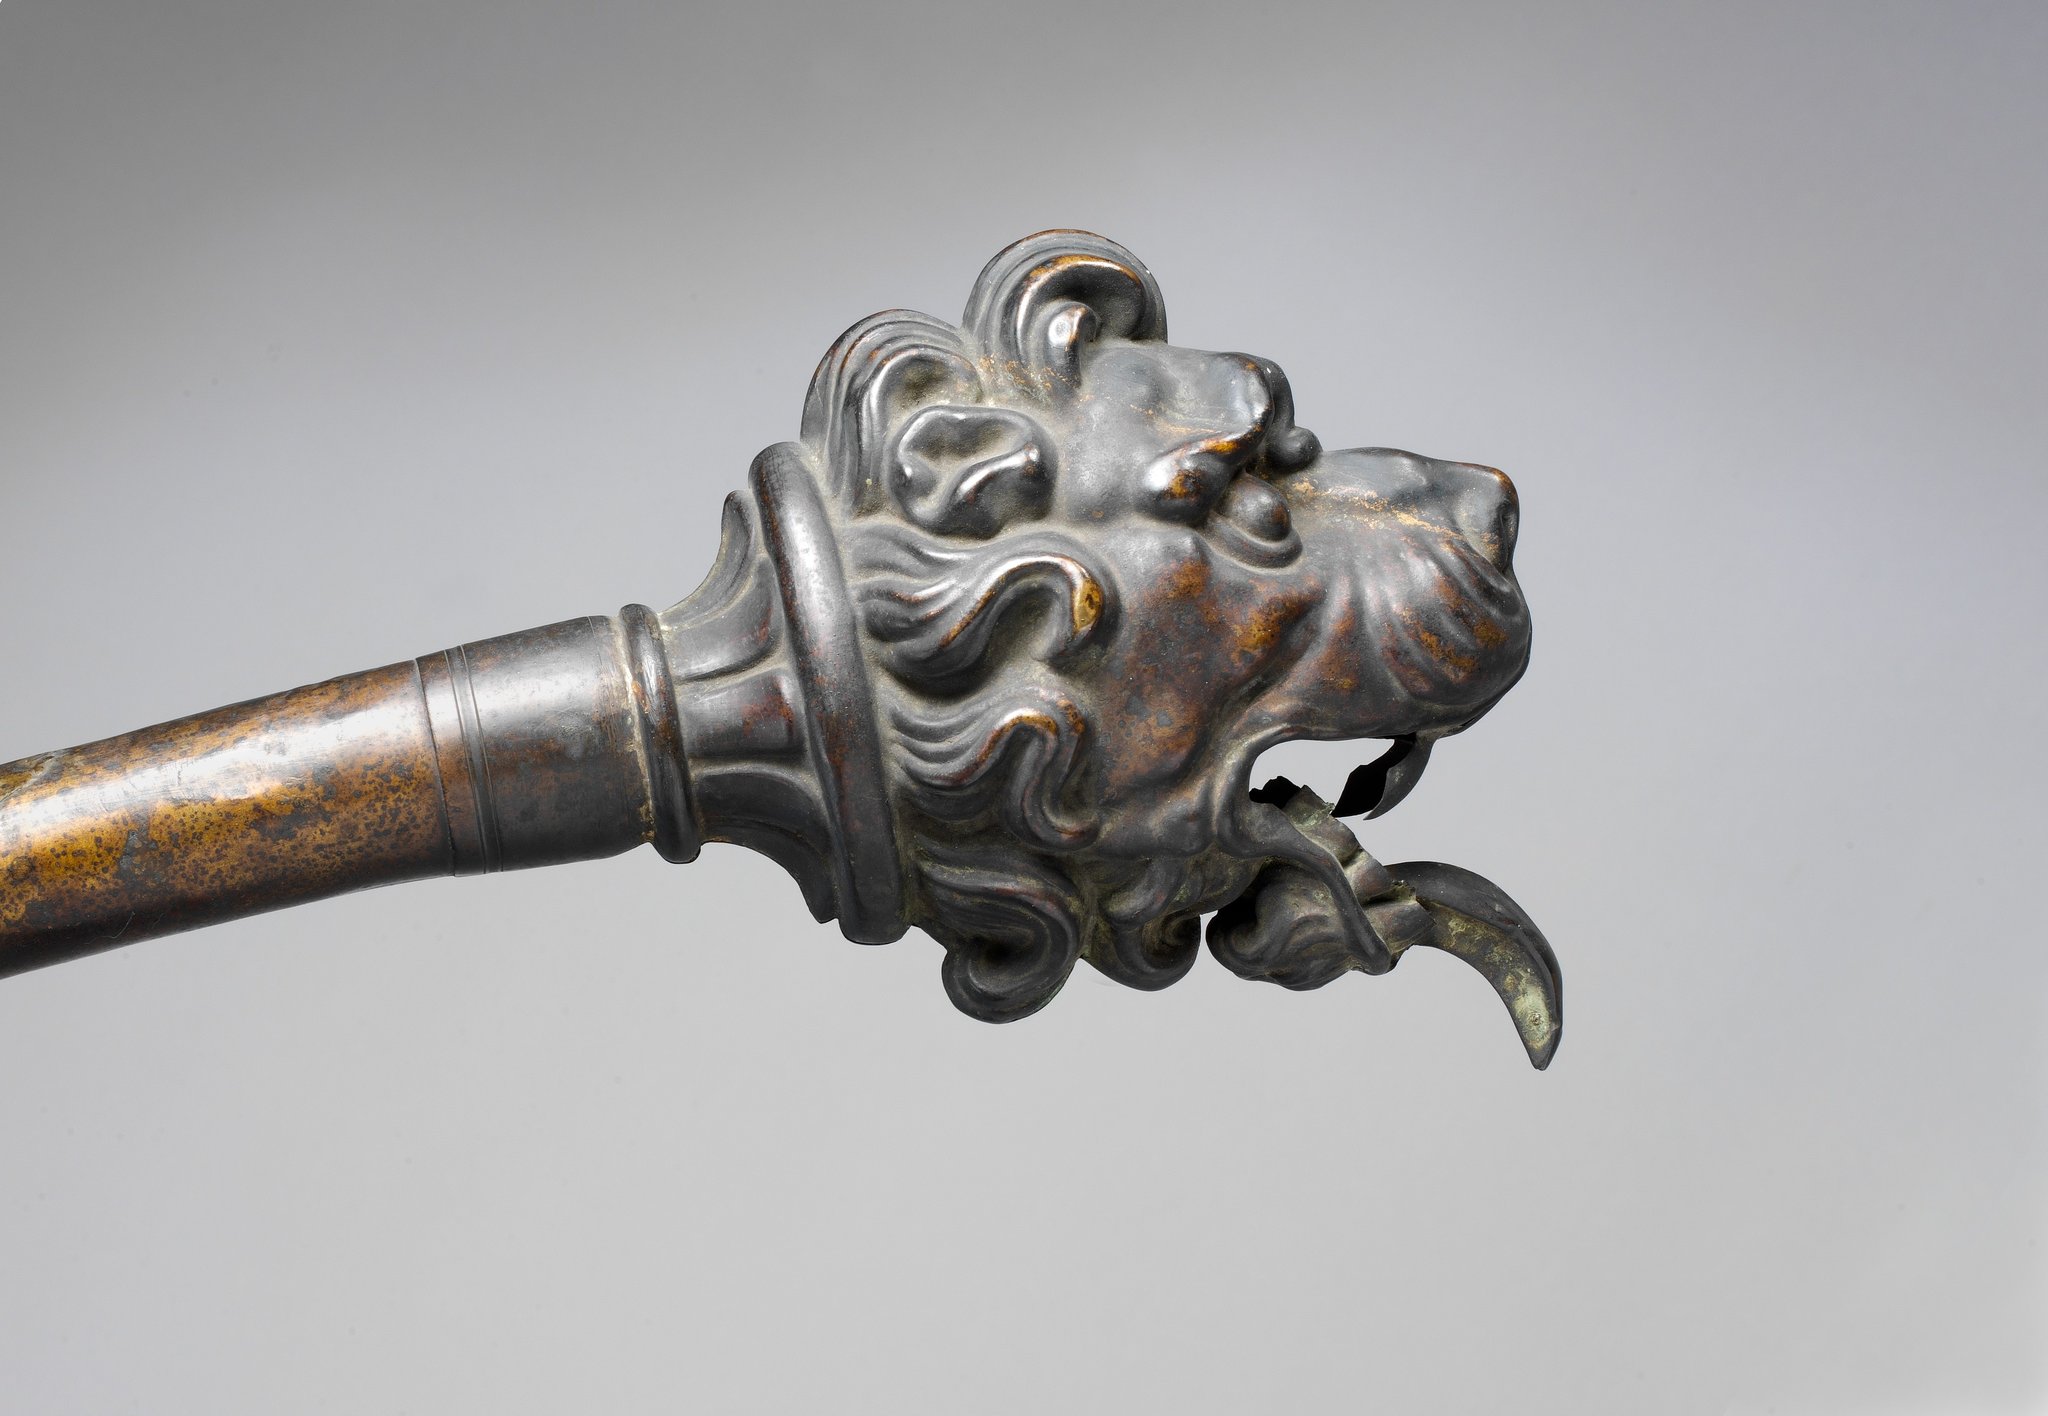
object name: serpon en metallo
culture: italian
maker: leopoldo franciolini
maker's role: maker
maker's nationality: italian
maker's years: 1844-1920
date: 1801-1900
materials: metal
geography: italy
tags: lions